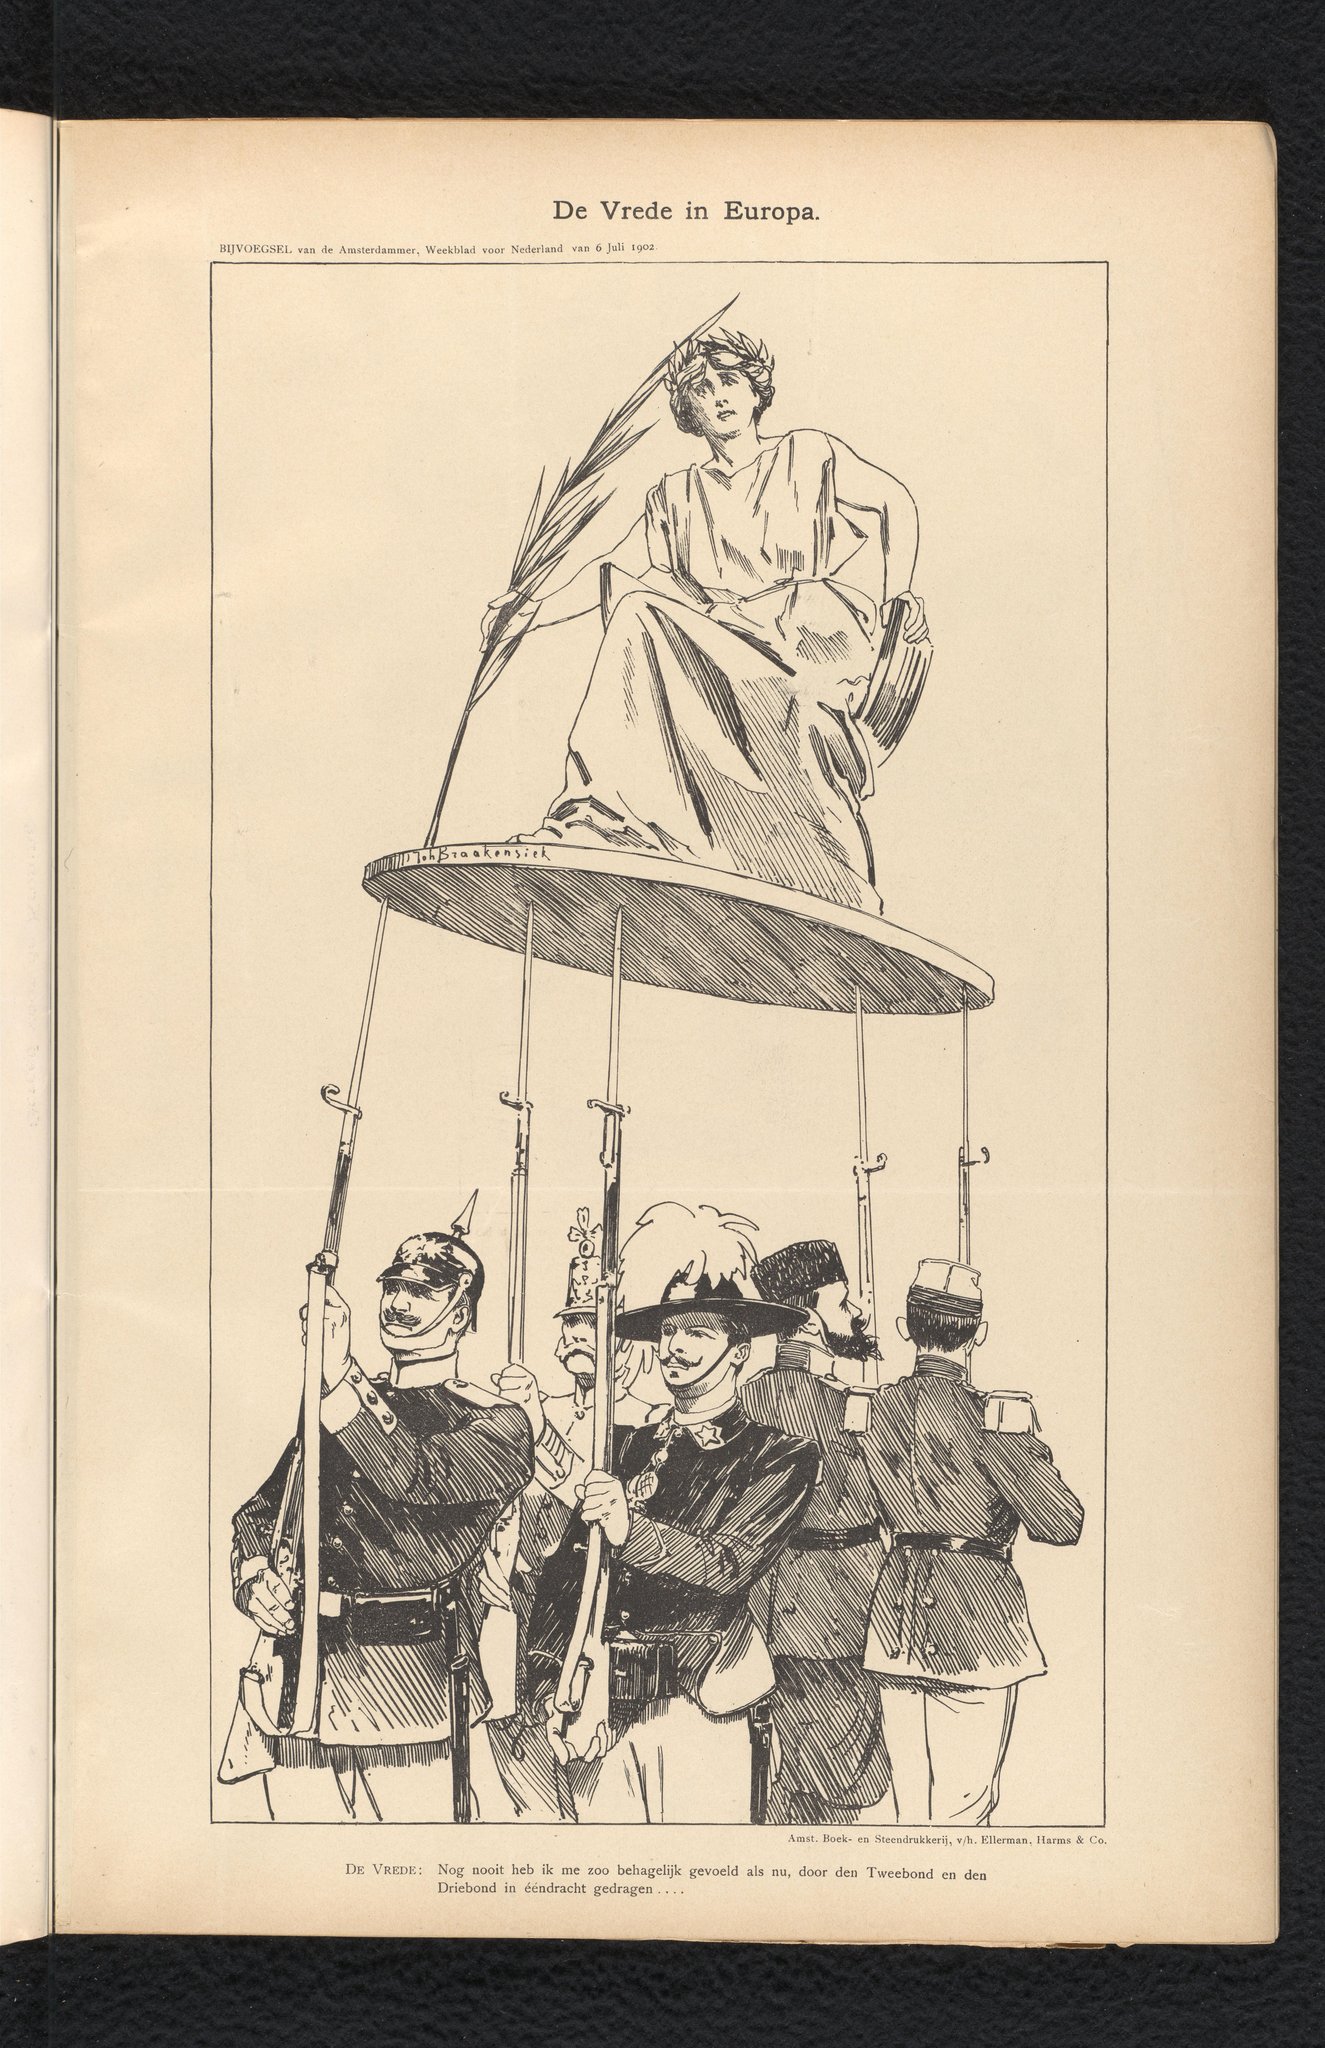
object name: cartoon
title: De Vrede in Europa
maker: johan braakensiek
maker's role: draughtsman, print maker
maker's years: 1858-1940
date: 1902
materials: paper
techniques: lithograph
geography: netherlands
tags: vienna, wilhelm ii (keizer van duitsland), new ruler raised on the shield - bb - female ruler, personifications of countries, nations, states, districts, etc., symbols, allegories of peace, 'pax'; 'pace' (ripa), political caricatures and satires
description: De Vrede zittend op een schild wankel balancerend op de bajonetten van vijf Europese landen. Vooraan de Duitse keizer Wilhelm II, de Italiaanse koning Victor Emanuel III van Italië en keizer Frans Jozef I van Oostenrijk. Op de rug gezien: Rusland en Frankrijk (?).